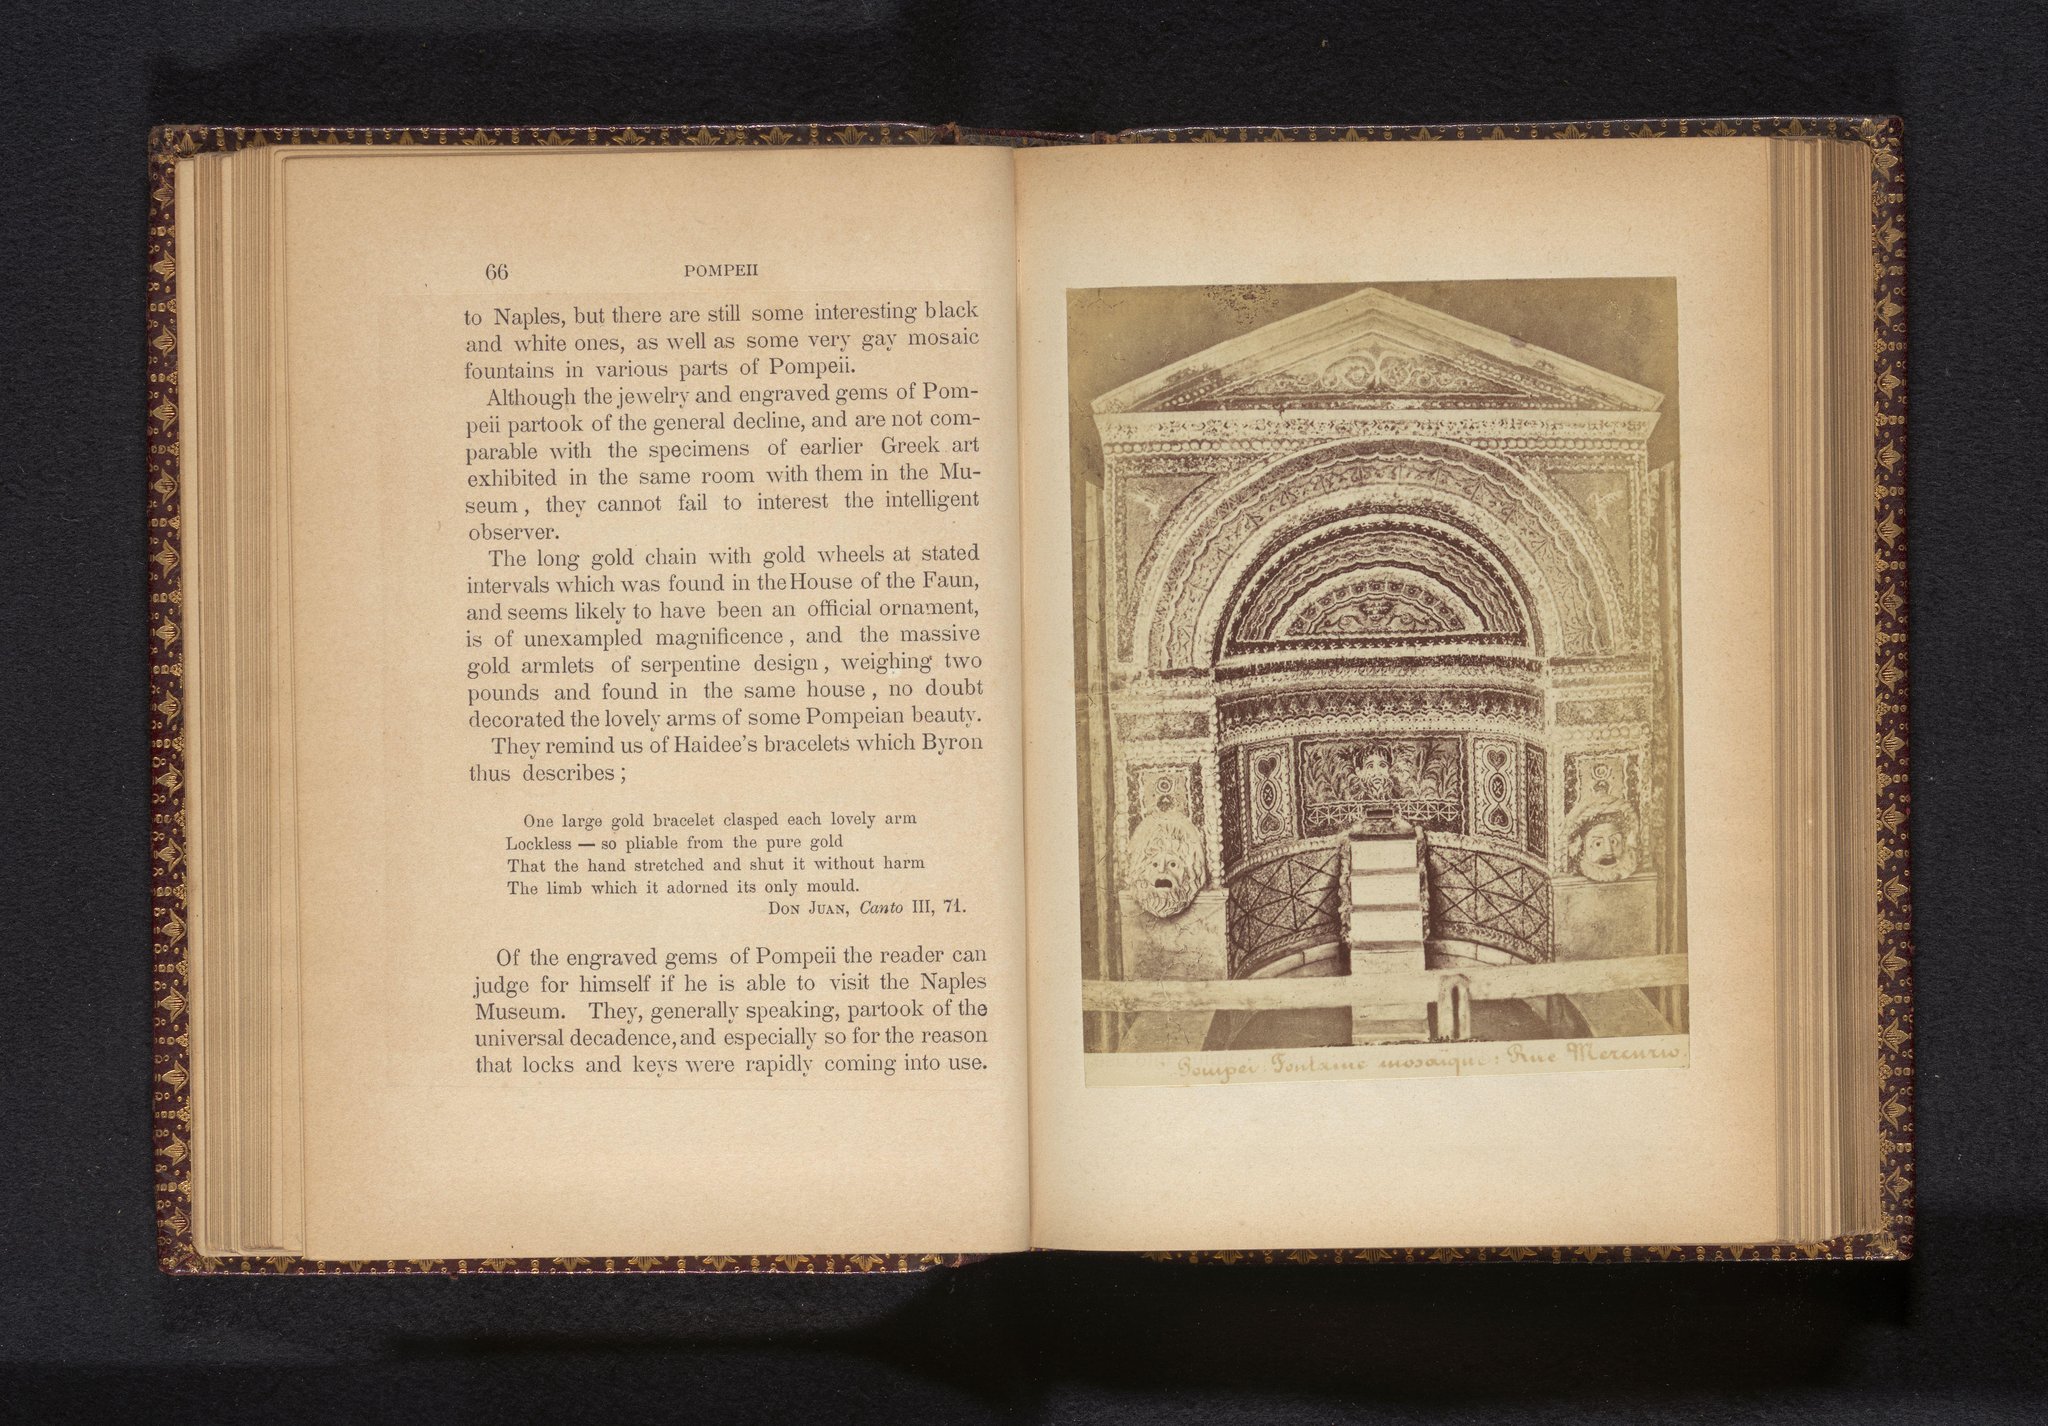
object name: page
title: Pompei Fontaine mosaïque: Rue Mercurio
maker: Anonymous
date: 1878-1888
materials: photographic support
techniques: albumen print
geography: via di mercurio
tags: ornamental fountain